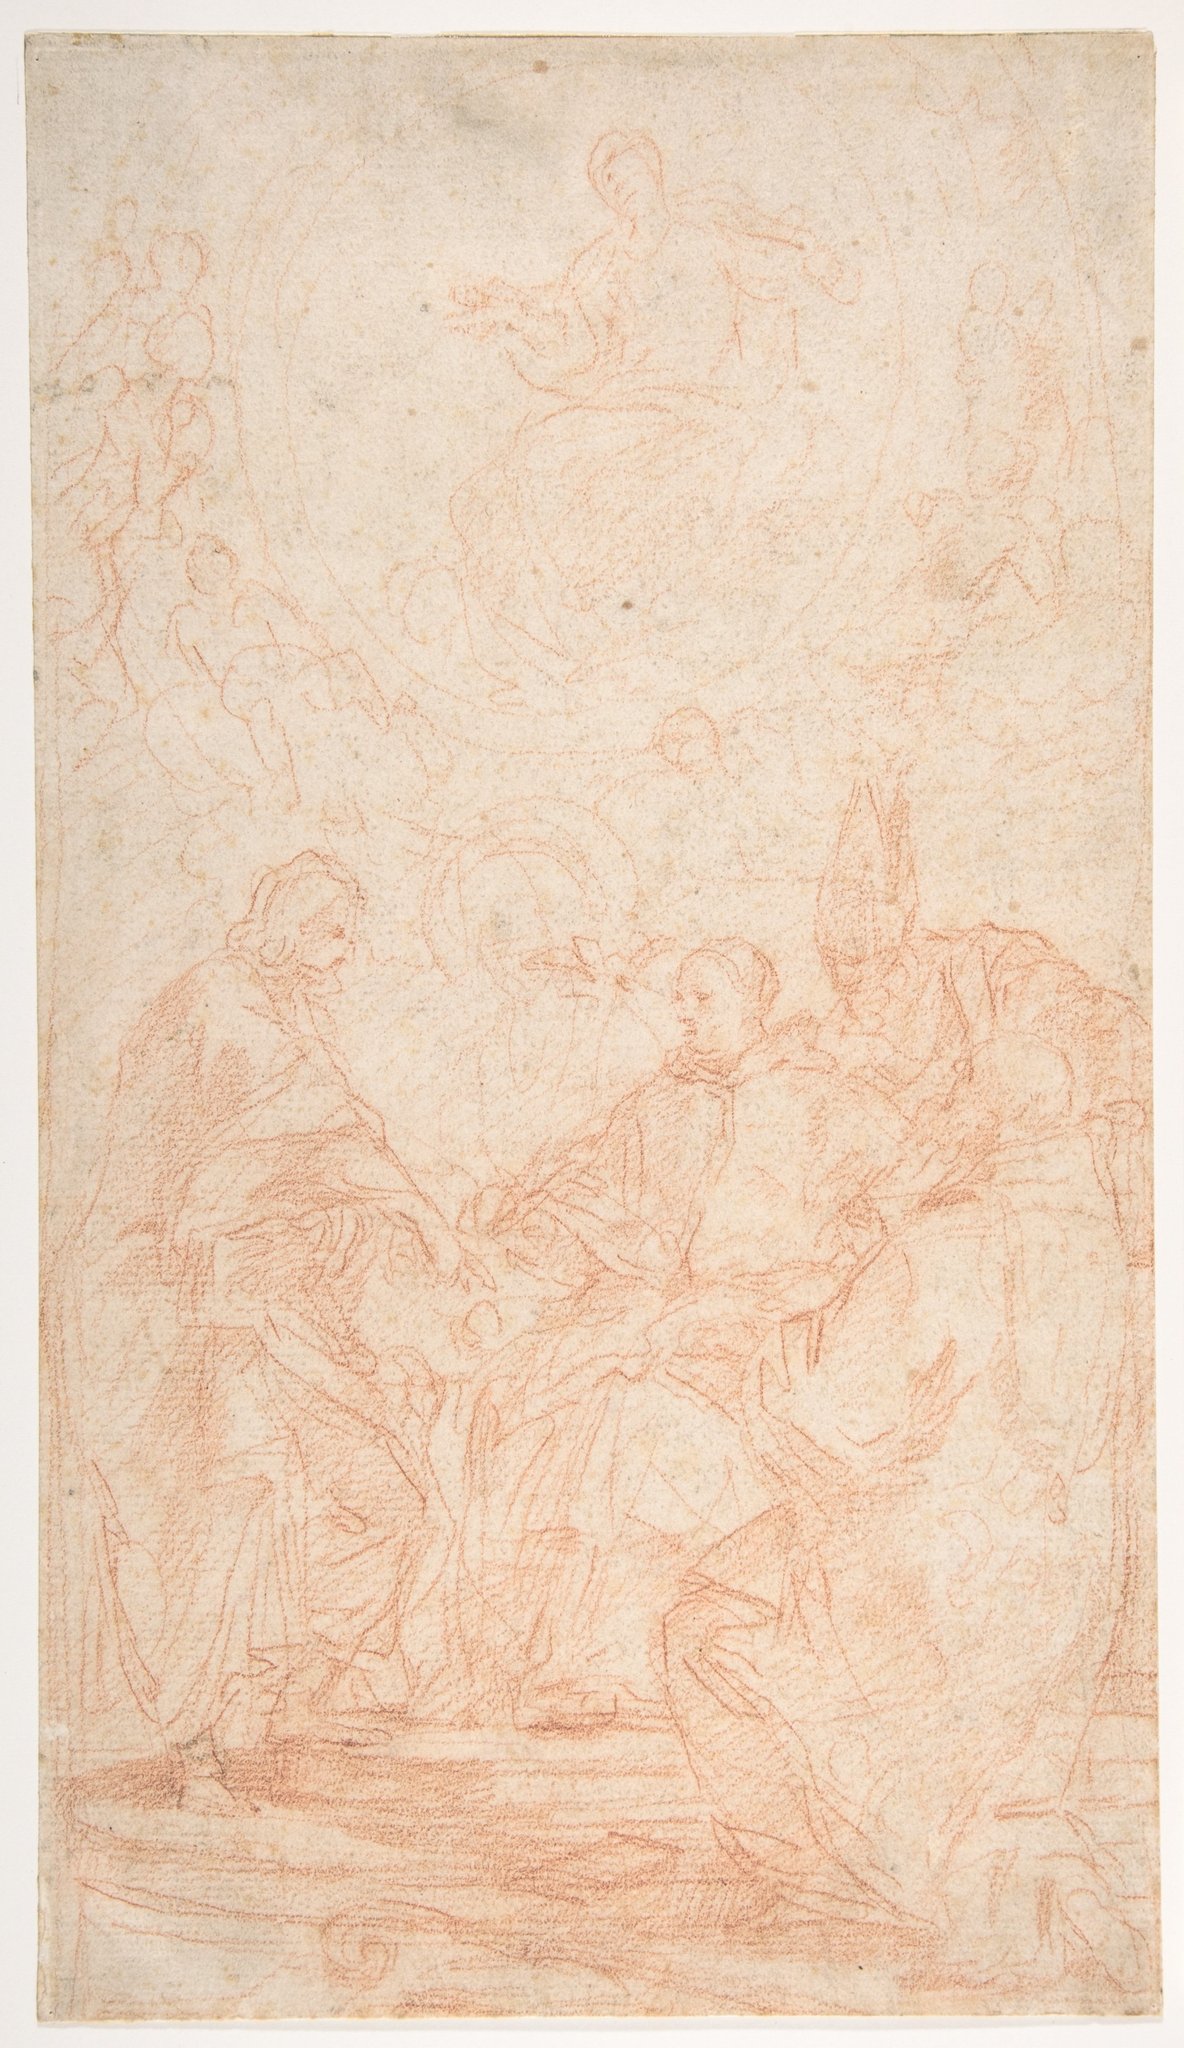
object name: drawing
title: The Virgin Immaculate and Four Male Saints (Study for The Dispute over the Immaculate Conception)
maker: carlo maratti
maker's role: artist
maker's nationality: italian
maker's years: 1625-1713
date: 1625-1713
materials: chalk, paper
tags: saint john the evangelist,virgin mary,saints